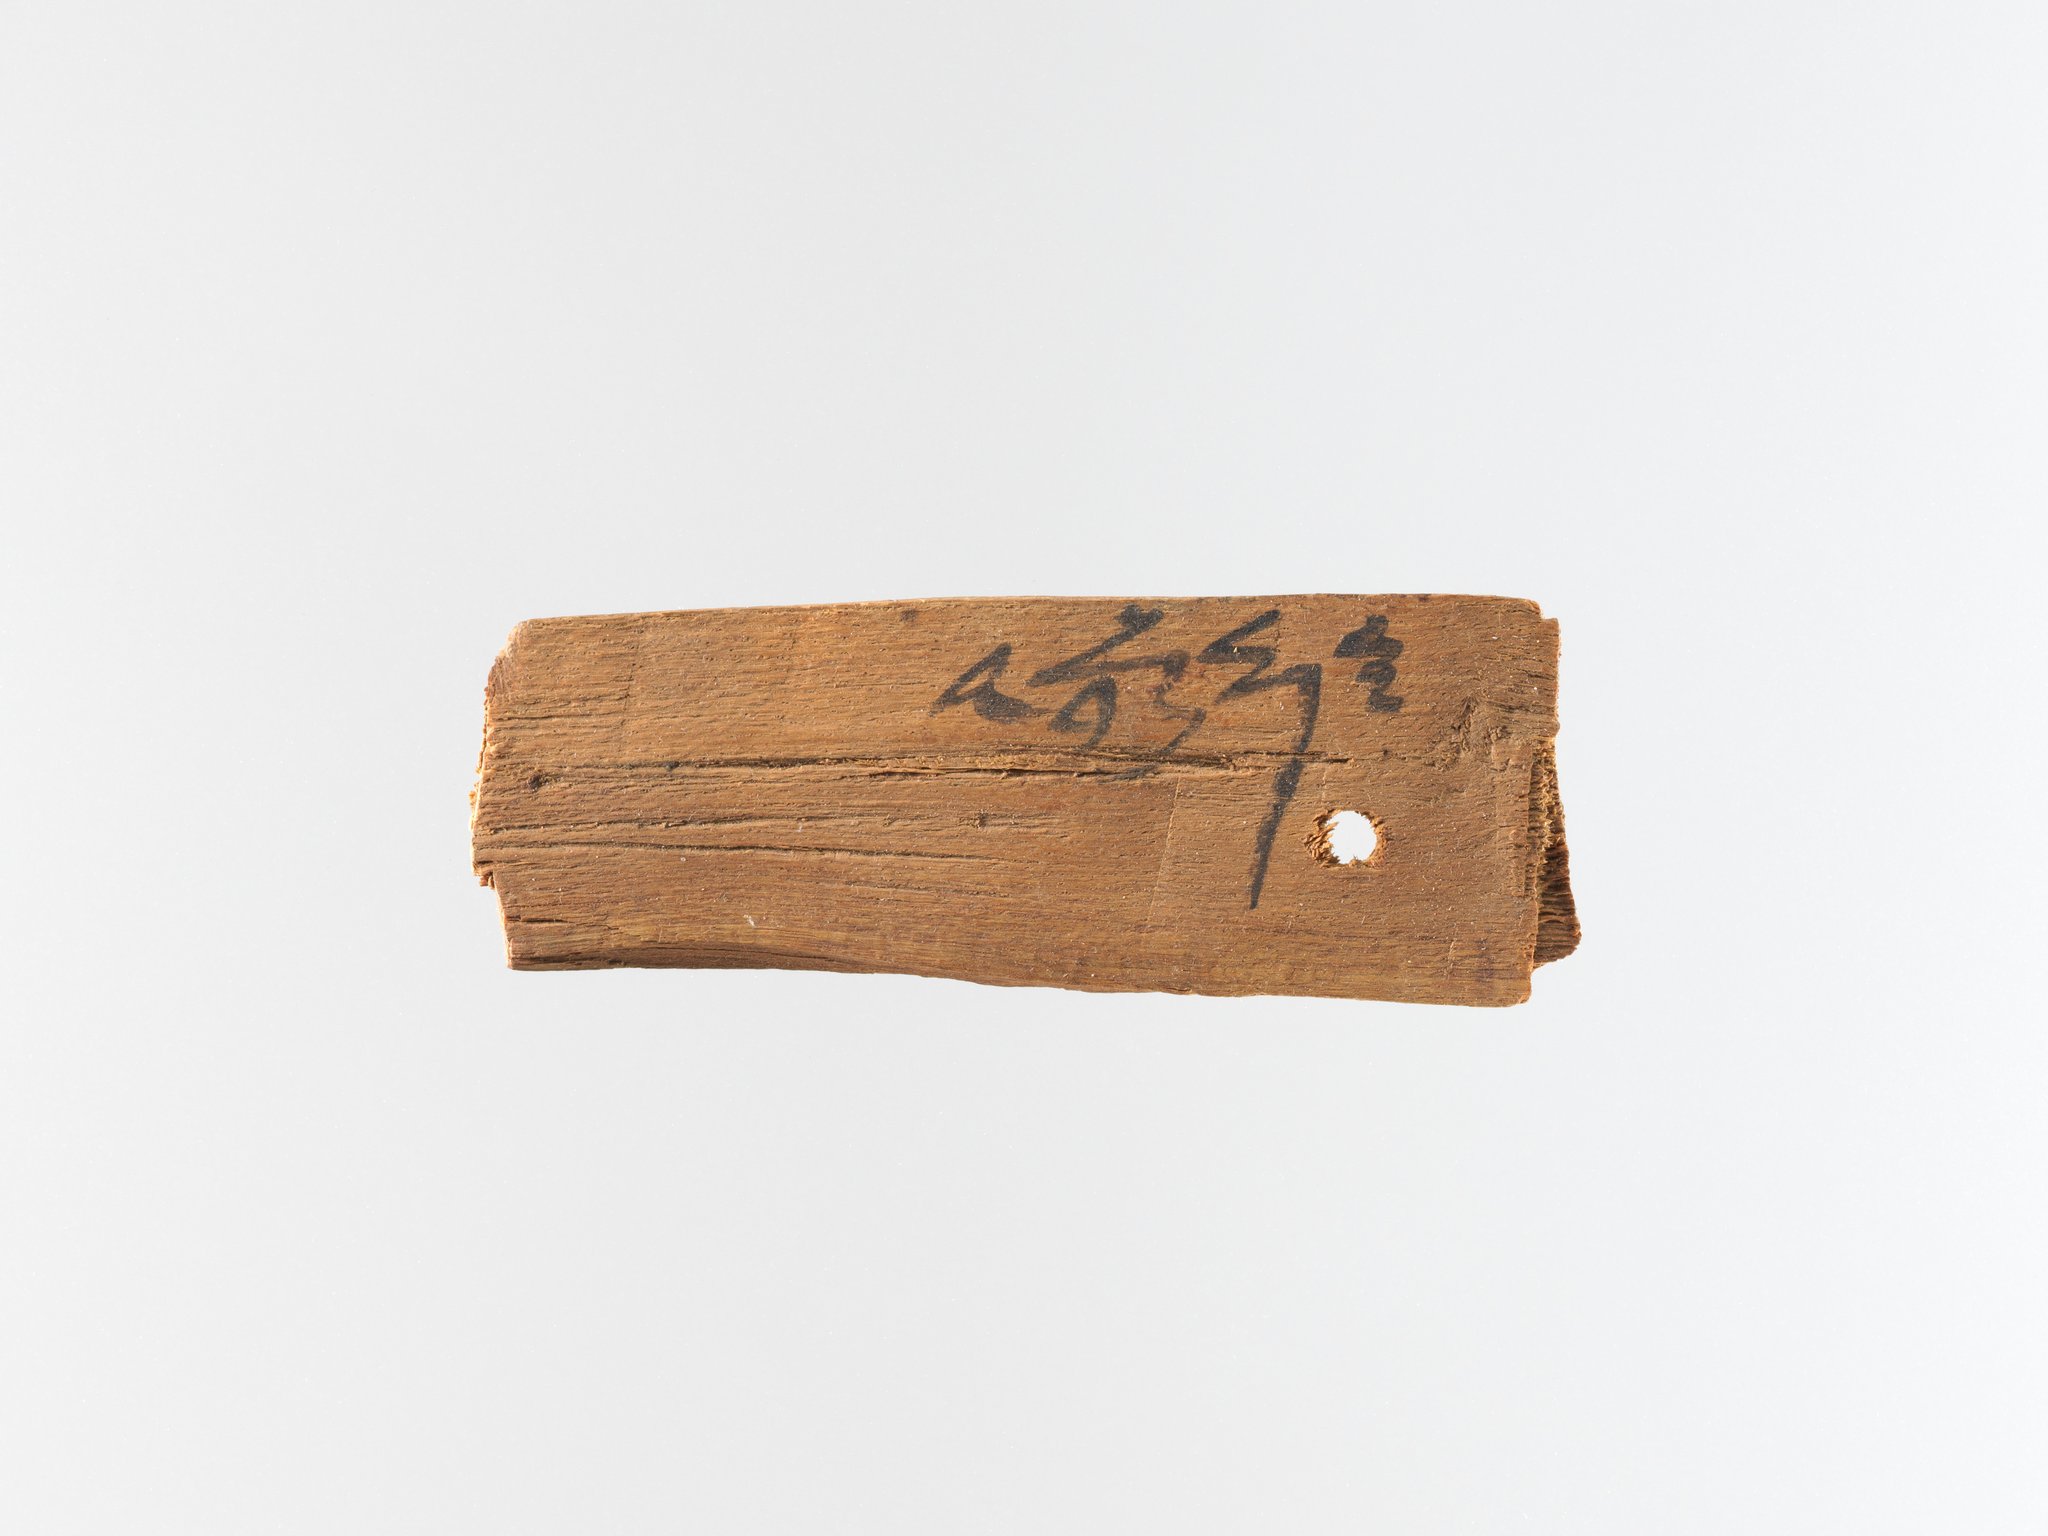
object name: mummy label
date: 1070-343 BCE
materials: wood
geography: egypt